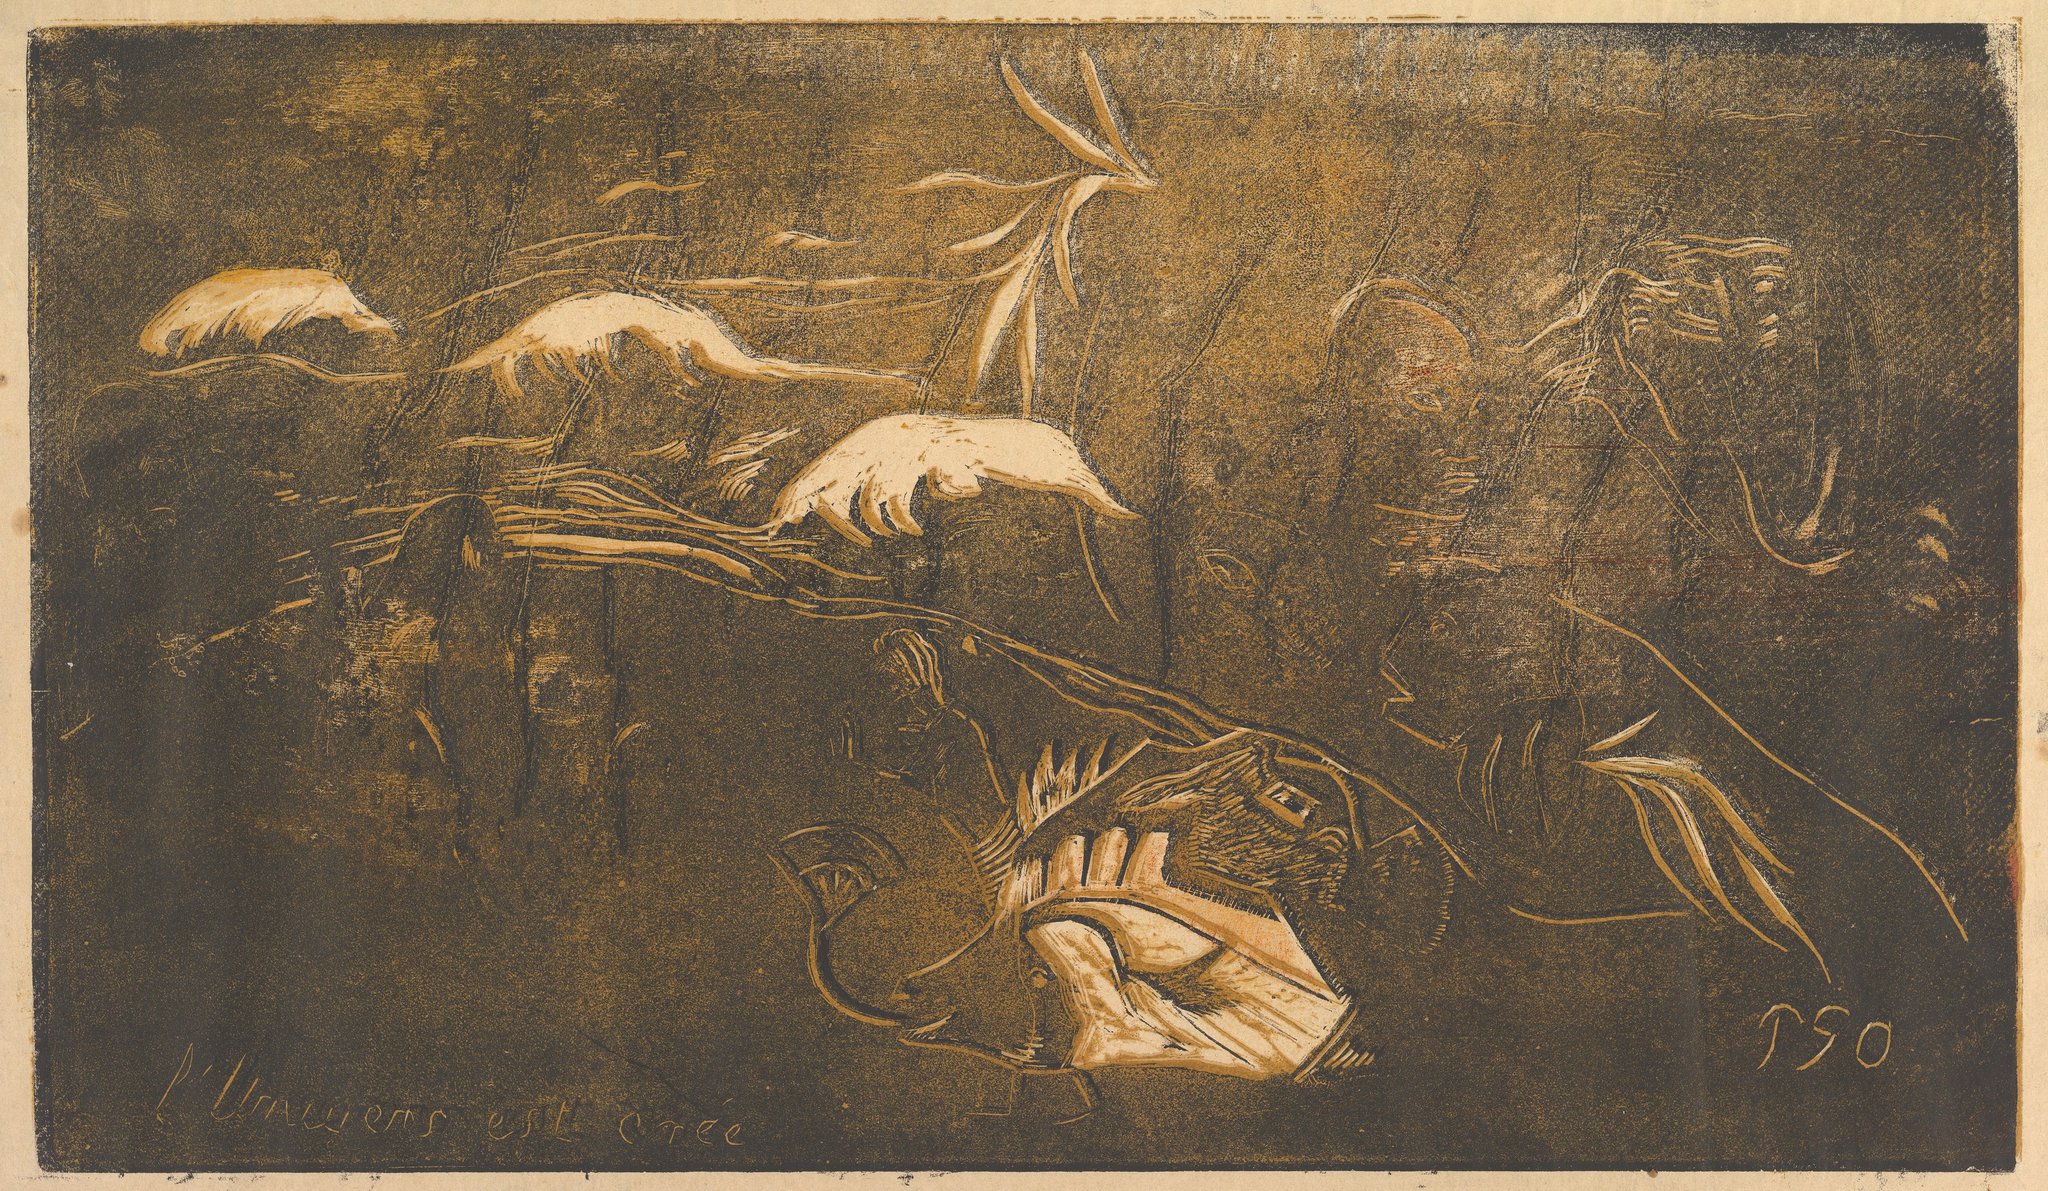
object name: print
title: The Universe Is Created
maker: paul gauguin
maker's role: artist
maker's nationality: french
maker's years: 1848-1903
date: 1893-1894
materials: paper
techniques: printing, woodcut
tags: leaves